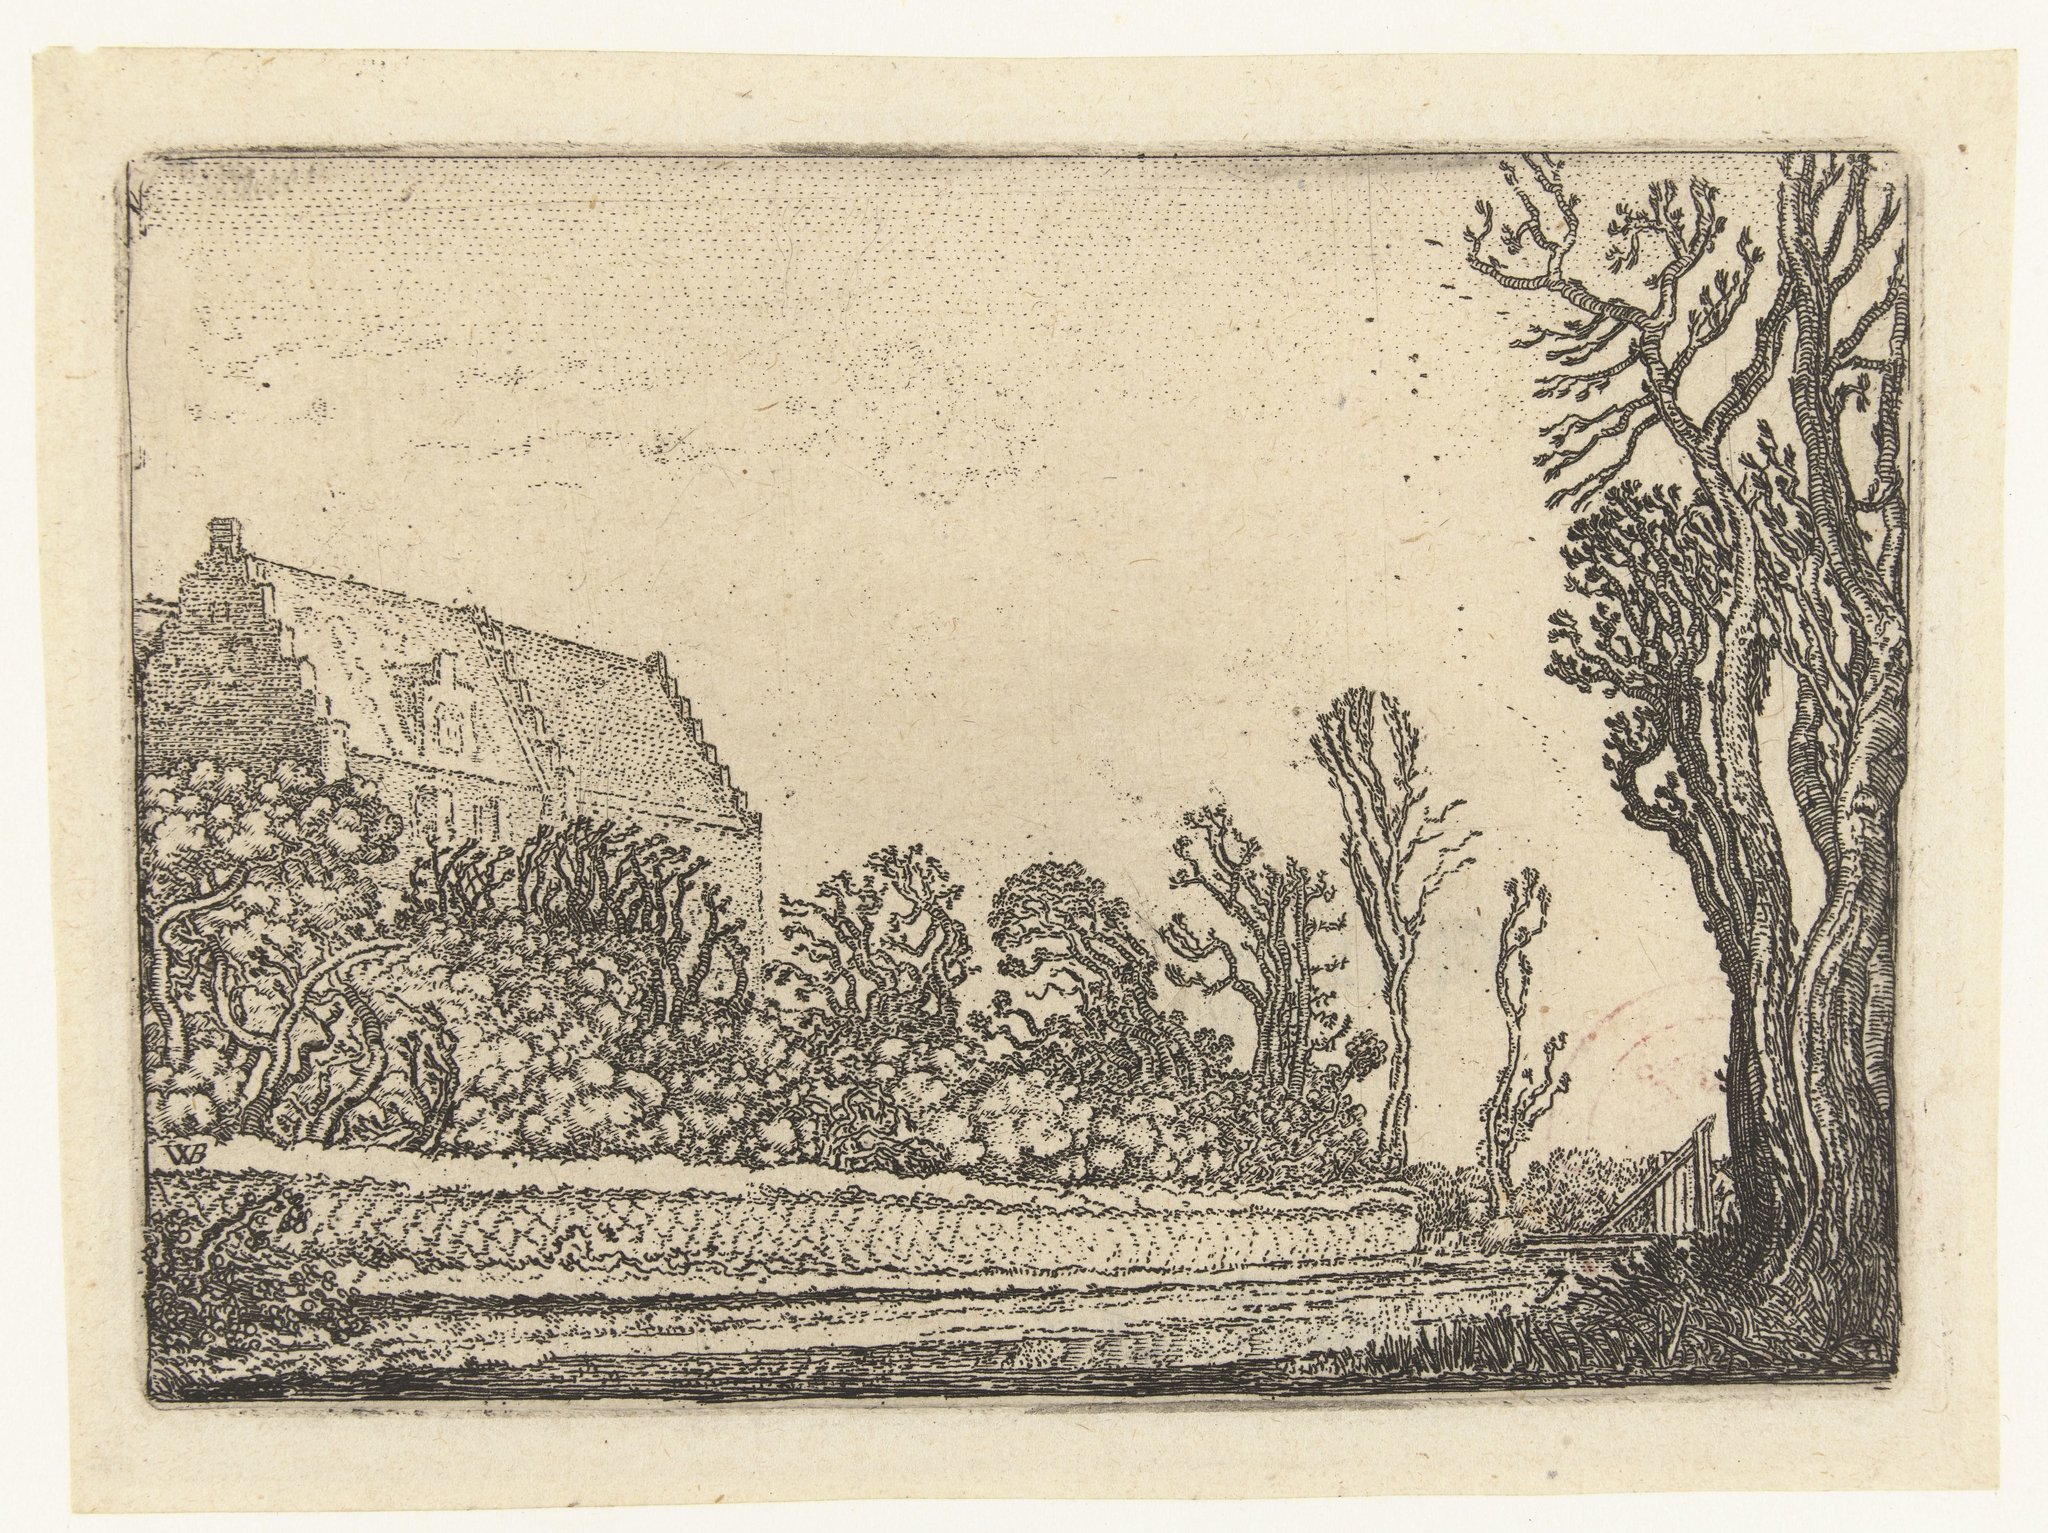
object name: print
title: Verscheyden Lantschapjes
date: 1621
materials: paper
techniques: etching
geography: netherlands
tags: country-house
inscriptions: collector's mark: Lugt 240